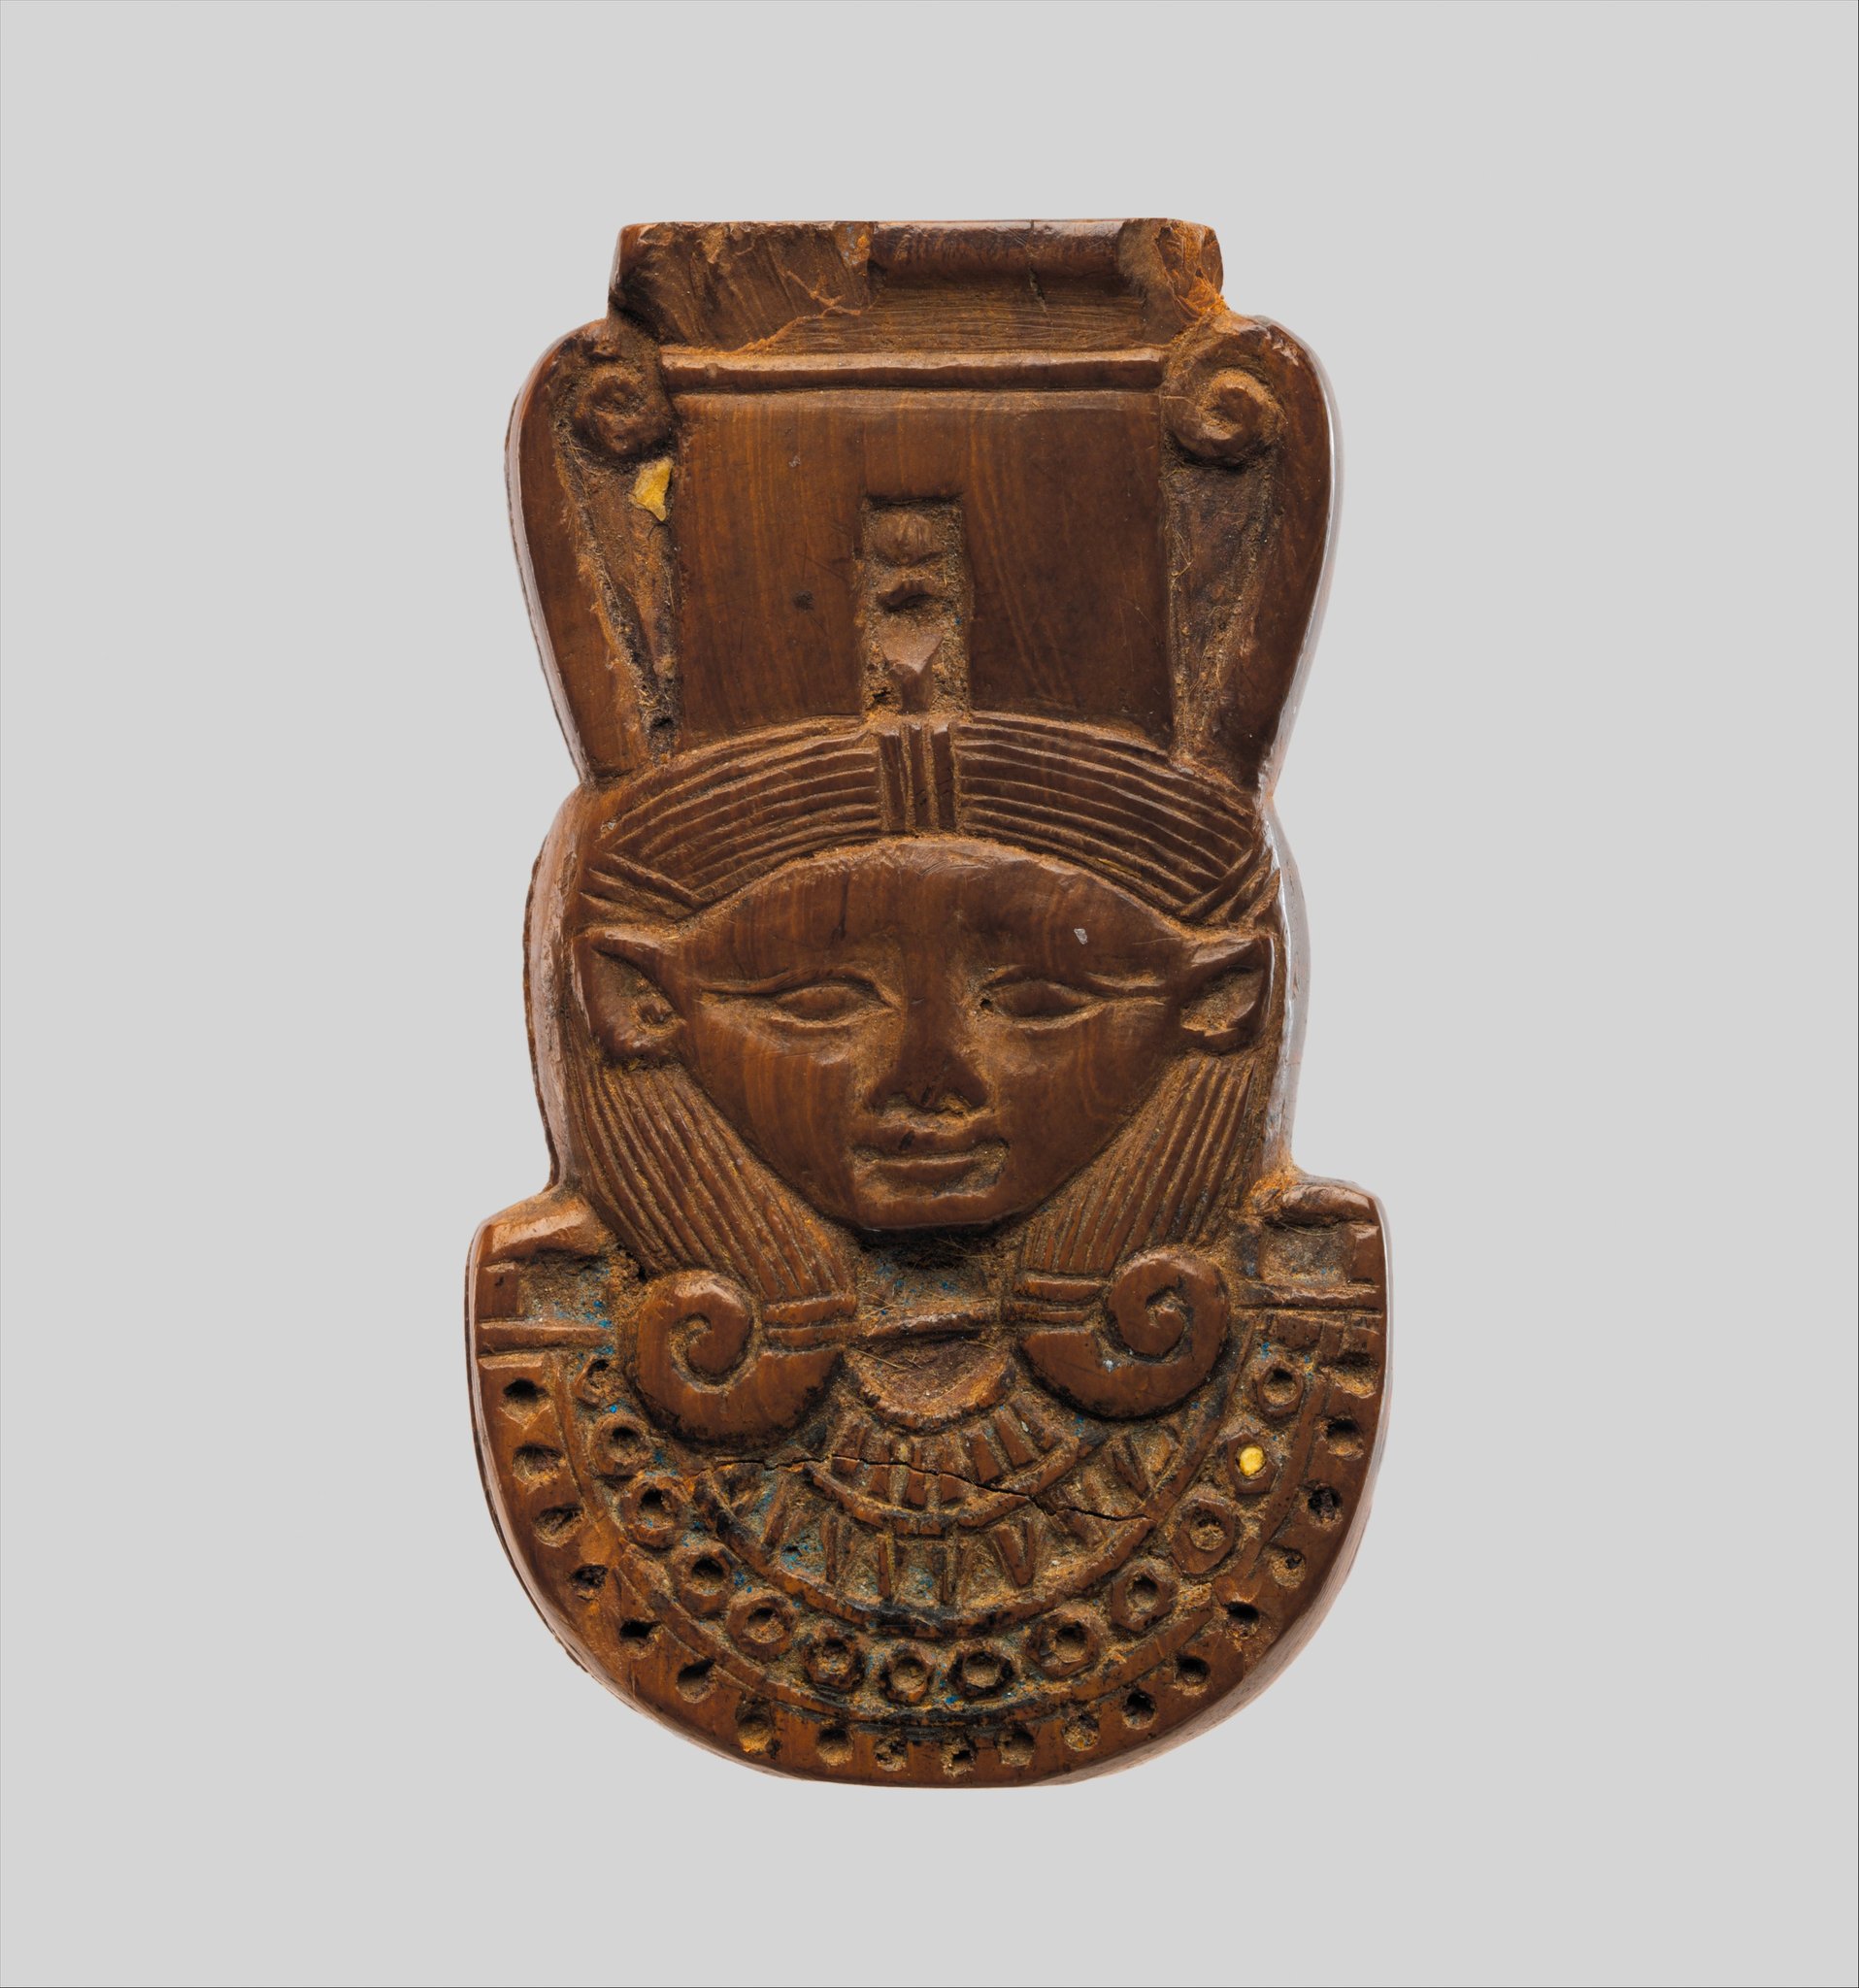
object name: hathor emblem, bat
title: Hathor / Bat emblem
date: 1570-1479 BCE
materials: ivory, pigment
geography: egypt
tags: hathor